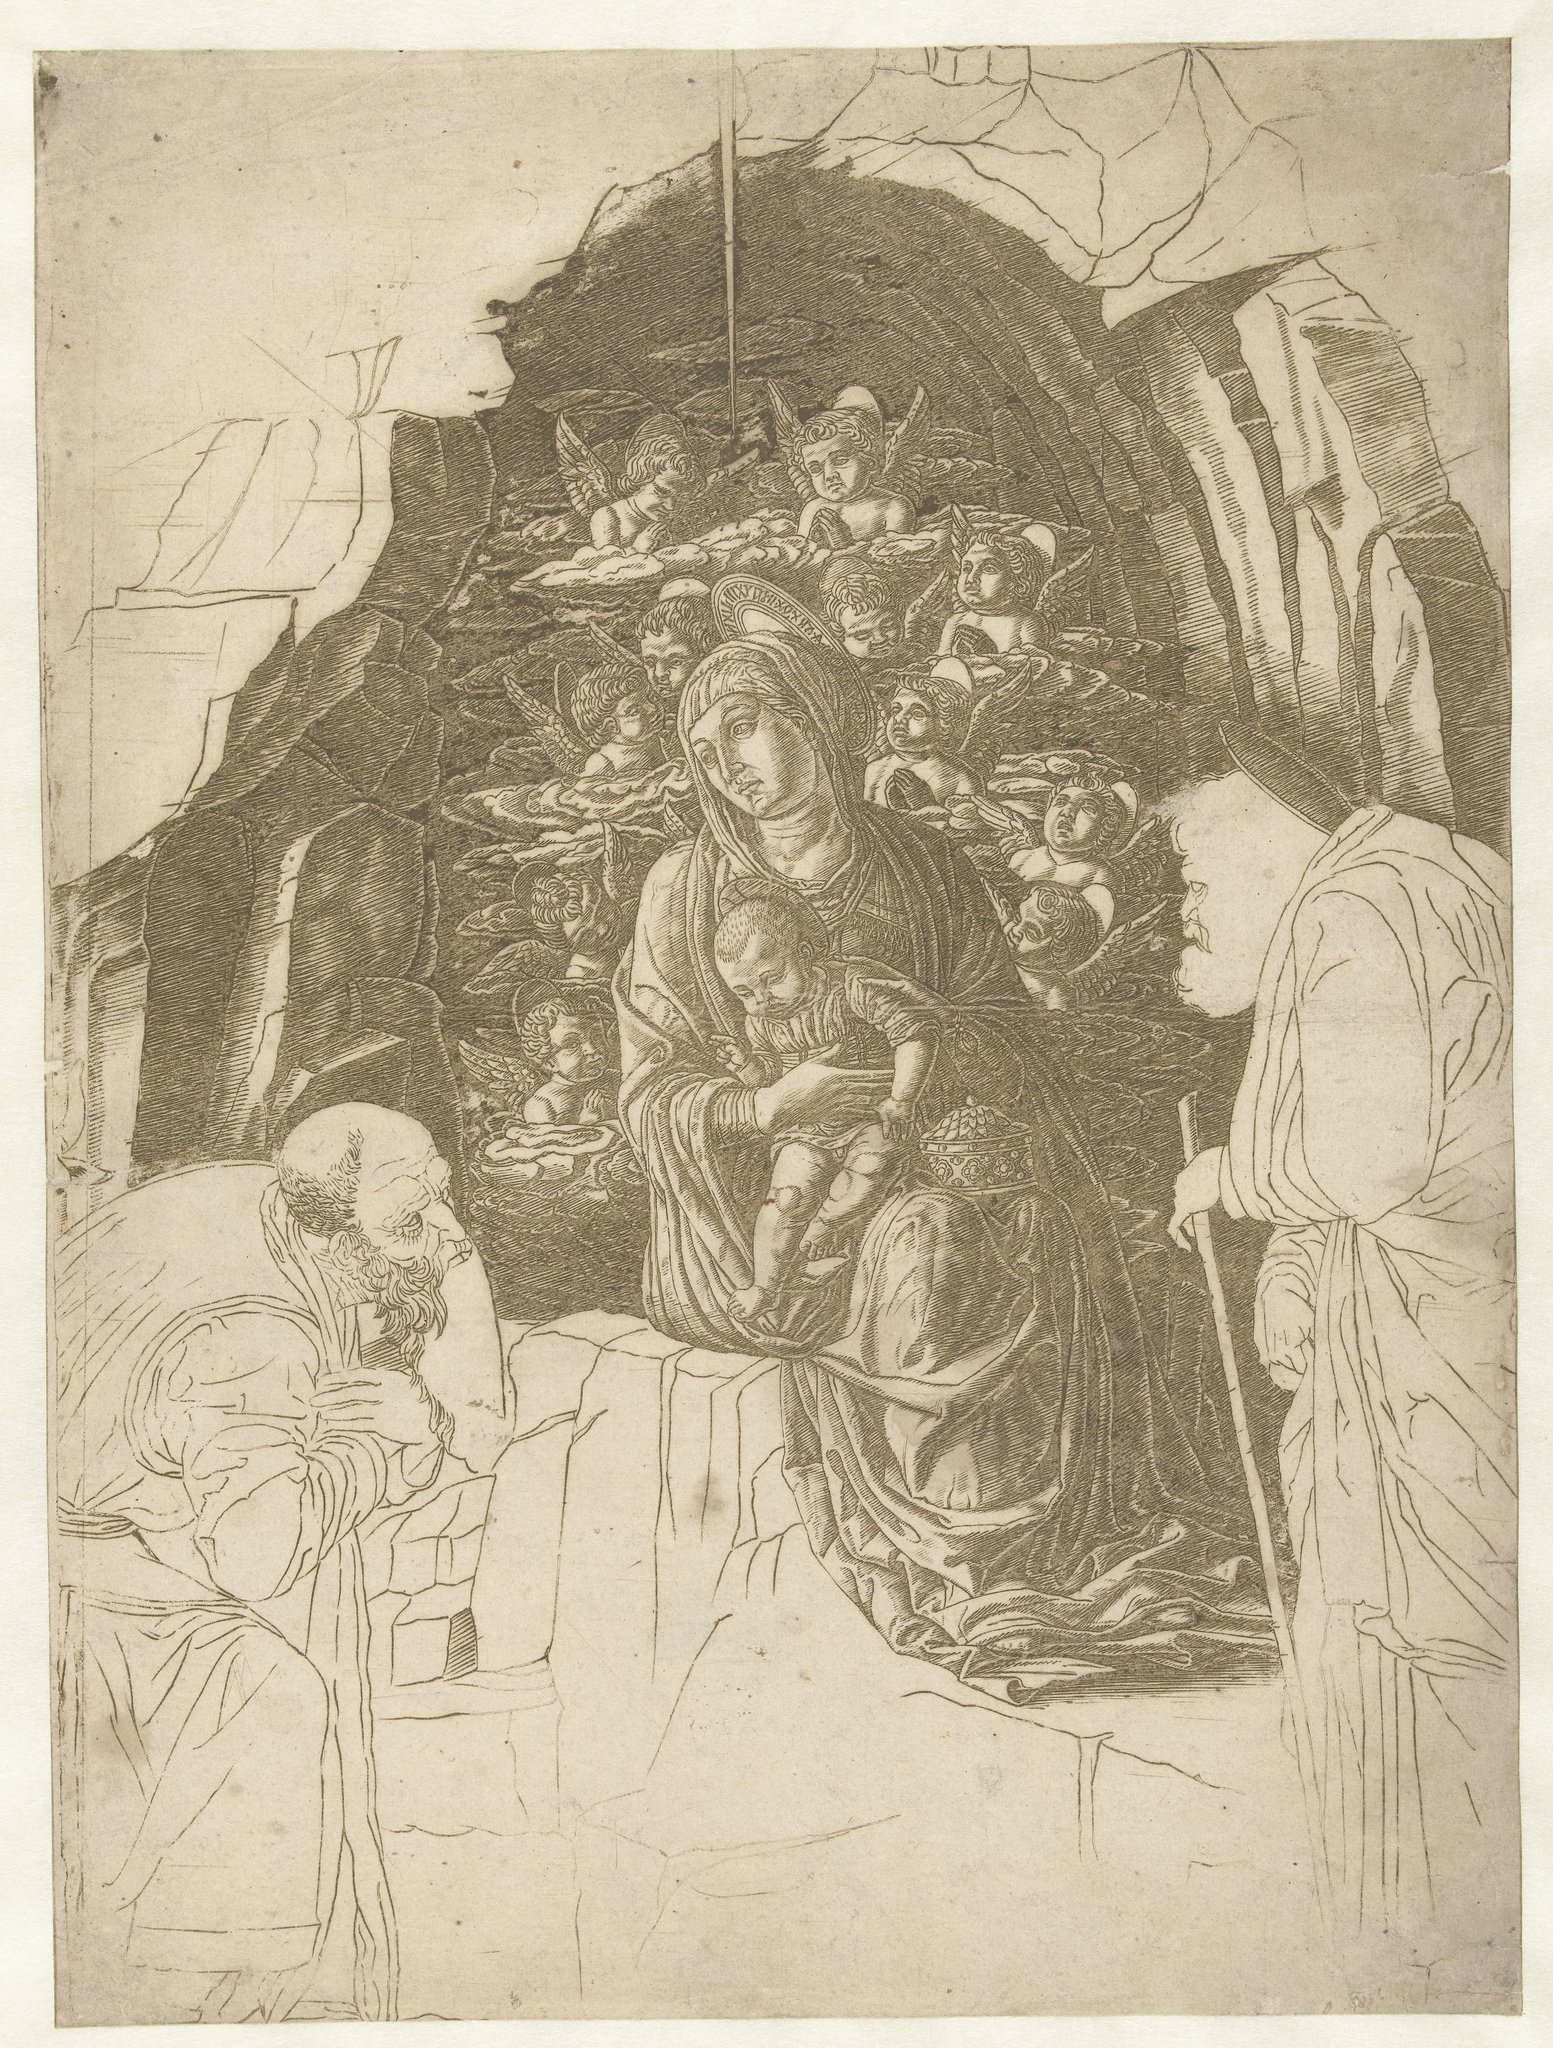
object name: print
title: Maria met kind omgeven door engelen in grot met Jozef en koning in aanbidding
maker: andrea mantegna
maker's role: print maker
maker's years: 1431-1506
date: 1475-1480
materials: paper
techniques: printing, engraving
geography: italy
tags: adoration of the kings: the wise men present their gifts to the christ-child (gold, frankincense and myrrh)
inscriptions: collector's mark: Lugt 2228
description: Kopie naar het middenpaneel van een triptiek van Andrea Mantegna met een Aanbidding door de drie koningen (zogenaamde Uffizi triptiek, collectie Uffizi, Florence). De graveur heeft een opvallende uitsnede genomen met slechts één koning. Dit is de enige prent uit de School van Mantegna waarbij een letterlijke overname zichtbaar is.